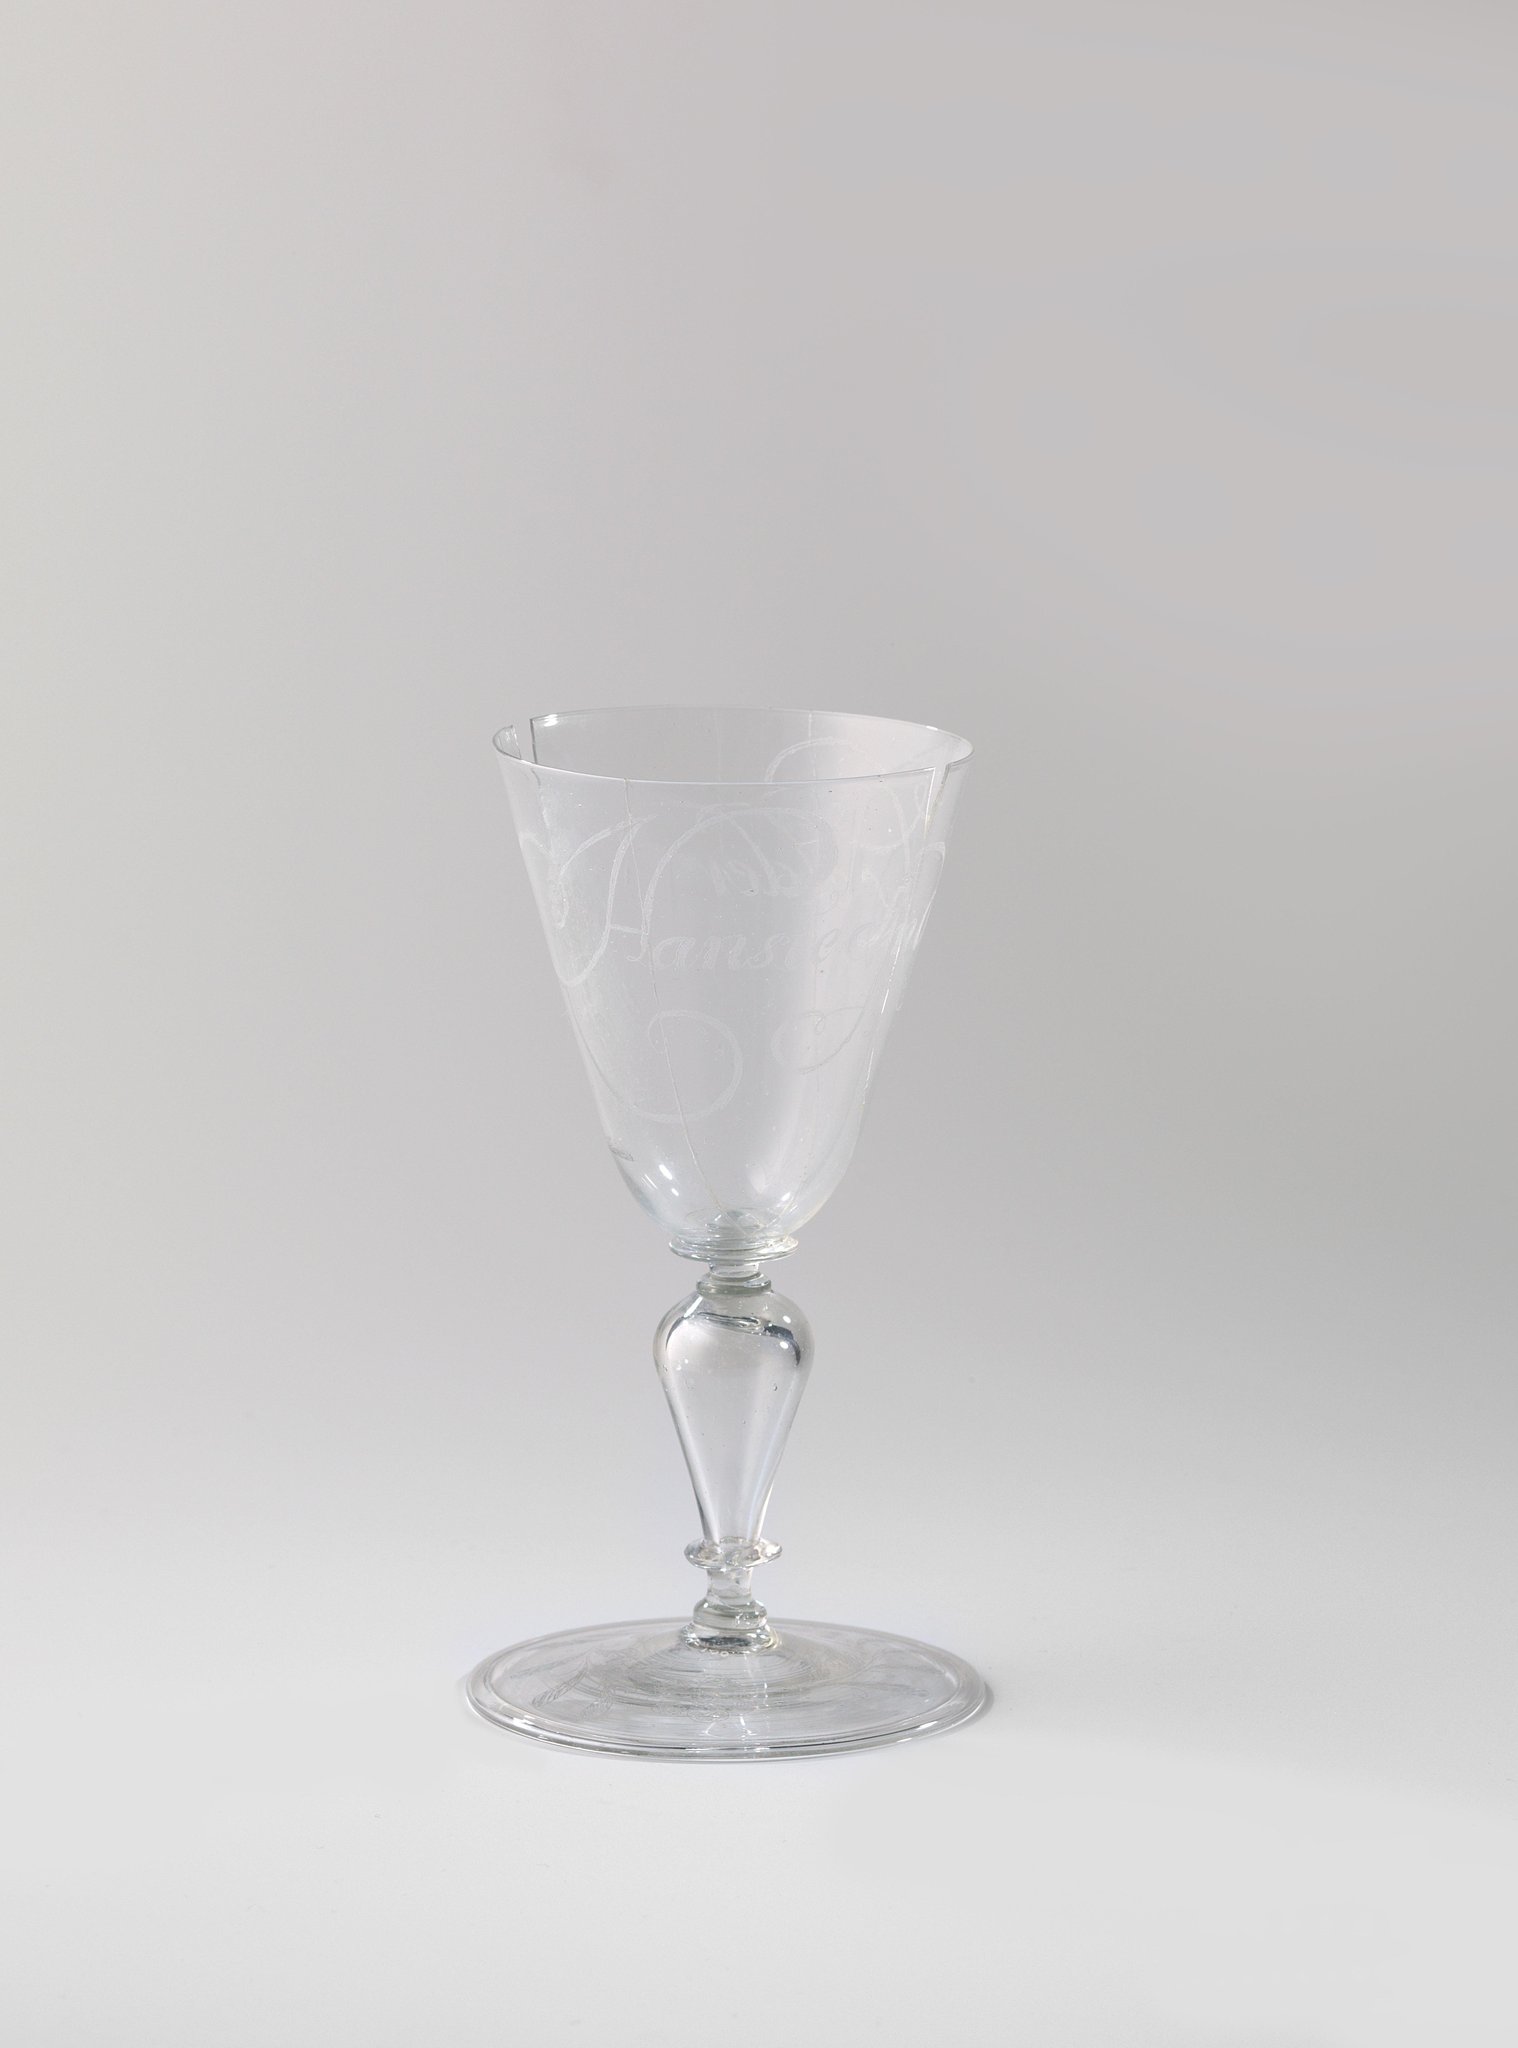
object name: goblet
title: Kelkglas met een zwangere vrouw en het opschrift: Hansie in de Kelder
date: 1680-1700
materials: glass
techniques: diamond point engraving, façon de venise, glassblowing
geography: rotterdam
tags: pregnancy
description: Lage voet met omgeslagen rand. Holle, balustervormige stam met twee platte schijven. Trechtervormige, aan de onderzijde afgeronde kelk, waarop een zwangere vrouw is gegraveerd en het opschrift 'Hansie in de Kelder'. Op de voet bloemtakken.